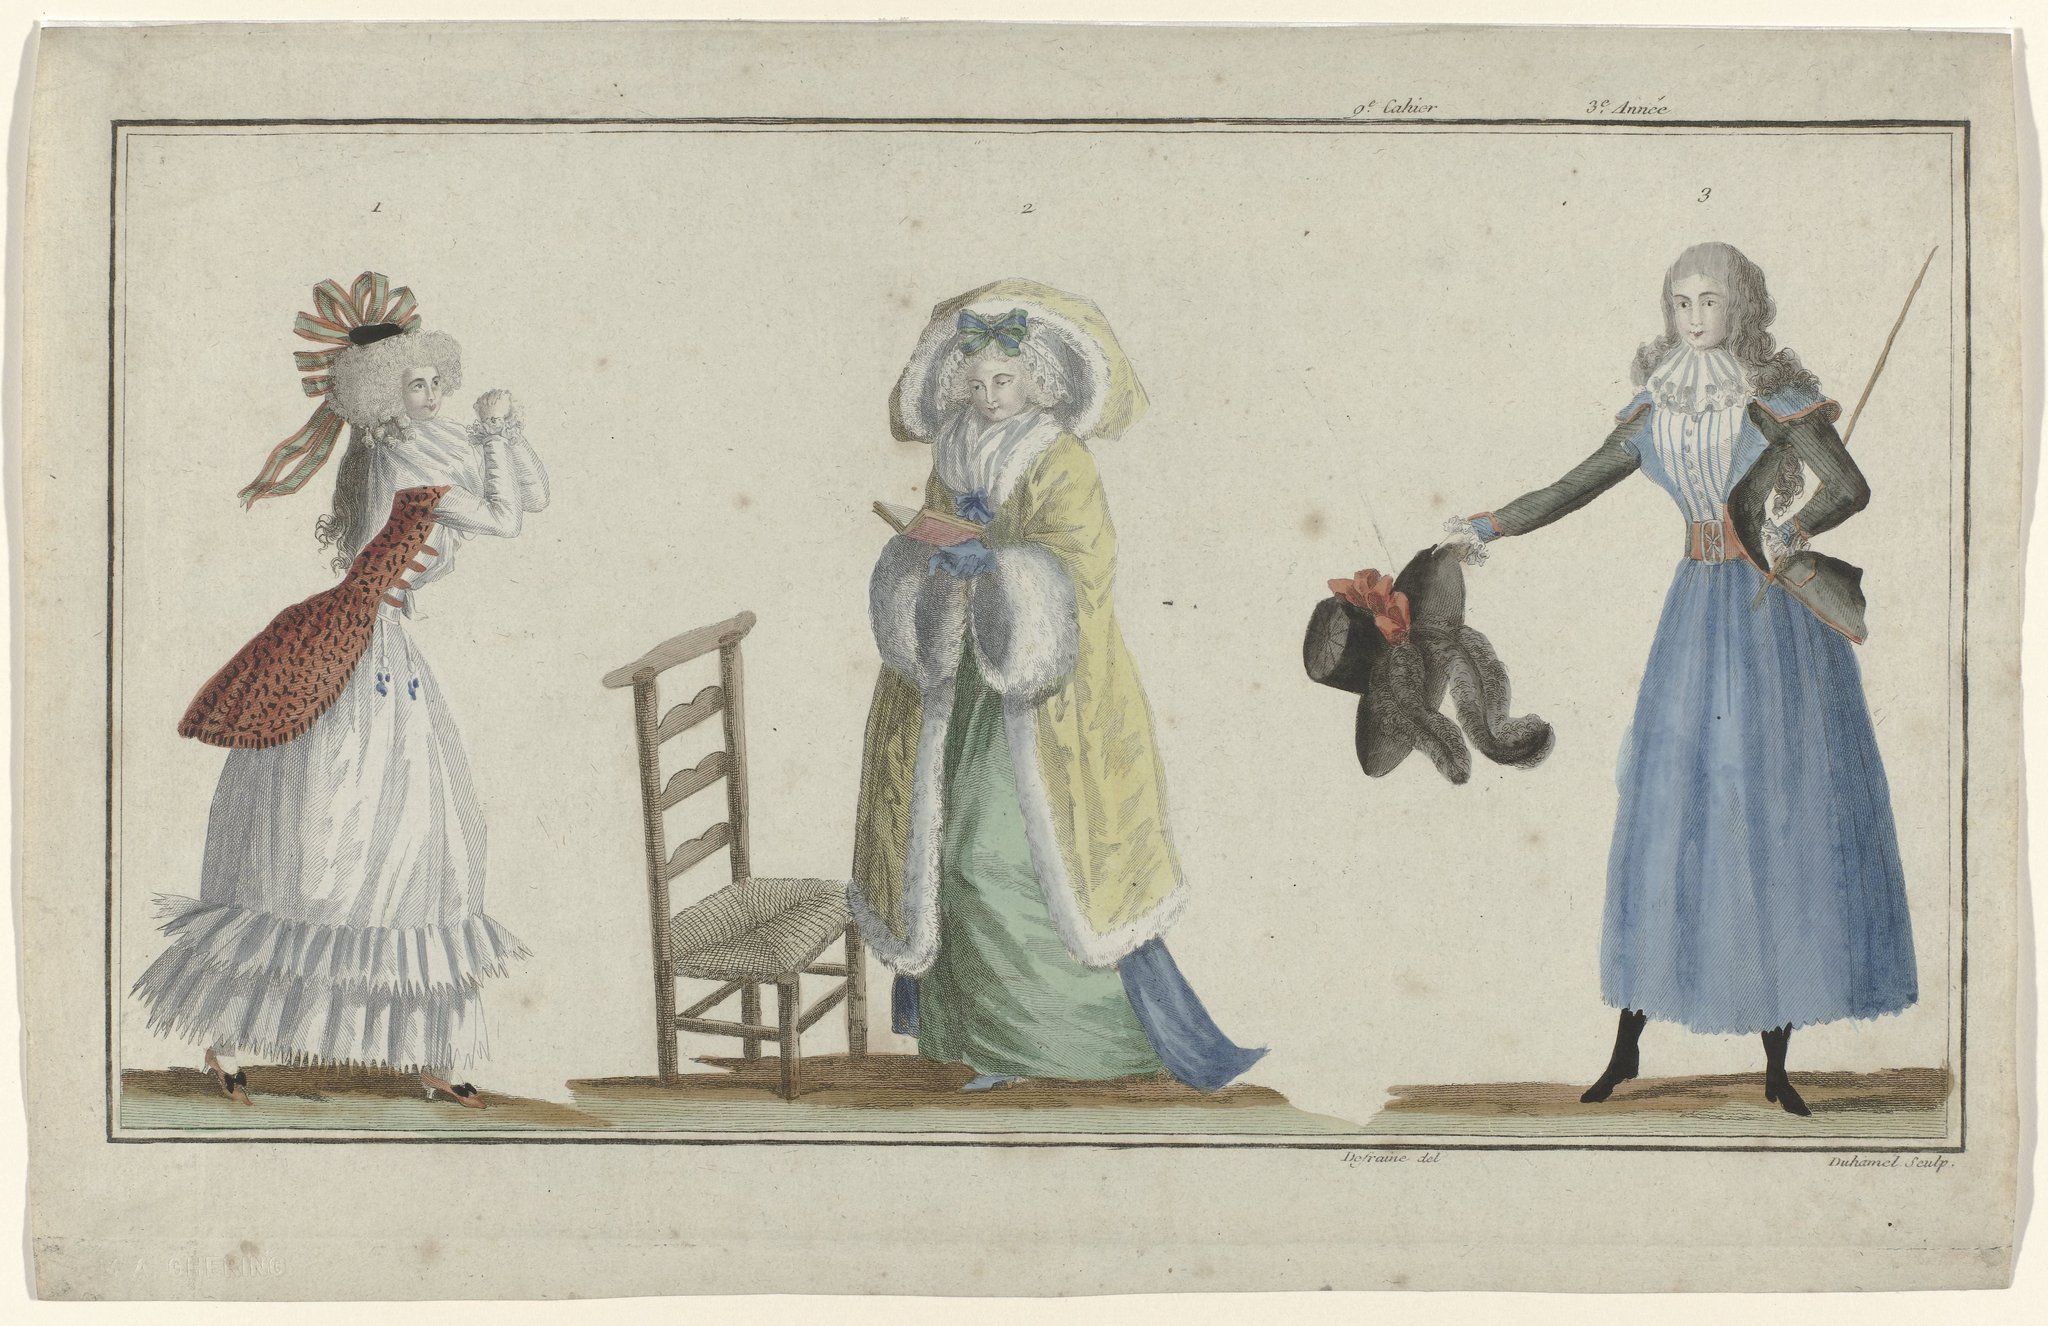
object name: fashion print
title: The First Fashion Magazine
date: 1788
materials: paper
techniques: engraving, hand coloring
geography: paris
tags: clothing for the upper part of the body (caraco) (+ women's clothes), walking-stick, staff, cane (+ women's clothes), clothing for the upper part of the body (vest) (+ women's clothes), cape (pelisse) (+ women's clothes), head-gear: cap (+ women's clothes), fashion plates, head-gear: hat (+ women's clothes), shoes, sandals (+ women's clothes), gloves, mittens, etc. (+ women's clothes), dress, gown (+ women's clothes), book - mm - book open, piece of clothing covering the breast or décolleté (fichu) (+ women's clothes)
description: The Cabinet des Modes ou les Modes Nouvelles first appeared on 15 November 1785. As the first real fashion magazine, it was published on a regular basis and wholly dedicated to news from the world of fashion. It was available by subscription only and distributed both in France and abroad. Each eight-page edition contained three hand-coloured engravings. After a year in print, the magazine changed its name to Magasin des Modes Nouvelles Françaises et Anglaises. Instead of three loose sheets, it now included a single fold-out plate depicting clothes and accessories. Publication of the Magasin ceased abruptly in 1789; after this, it was most likely succeeded by the Journal de la Mode et du Goût.